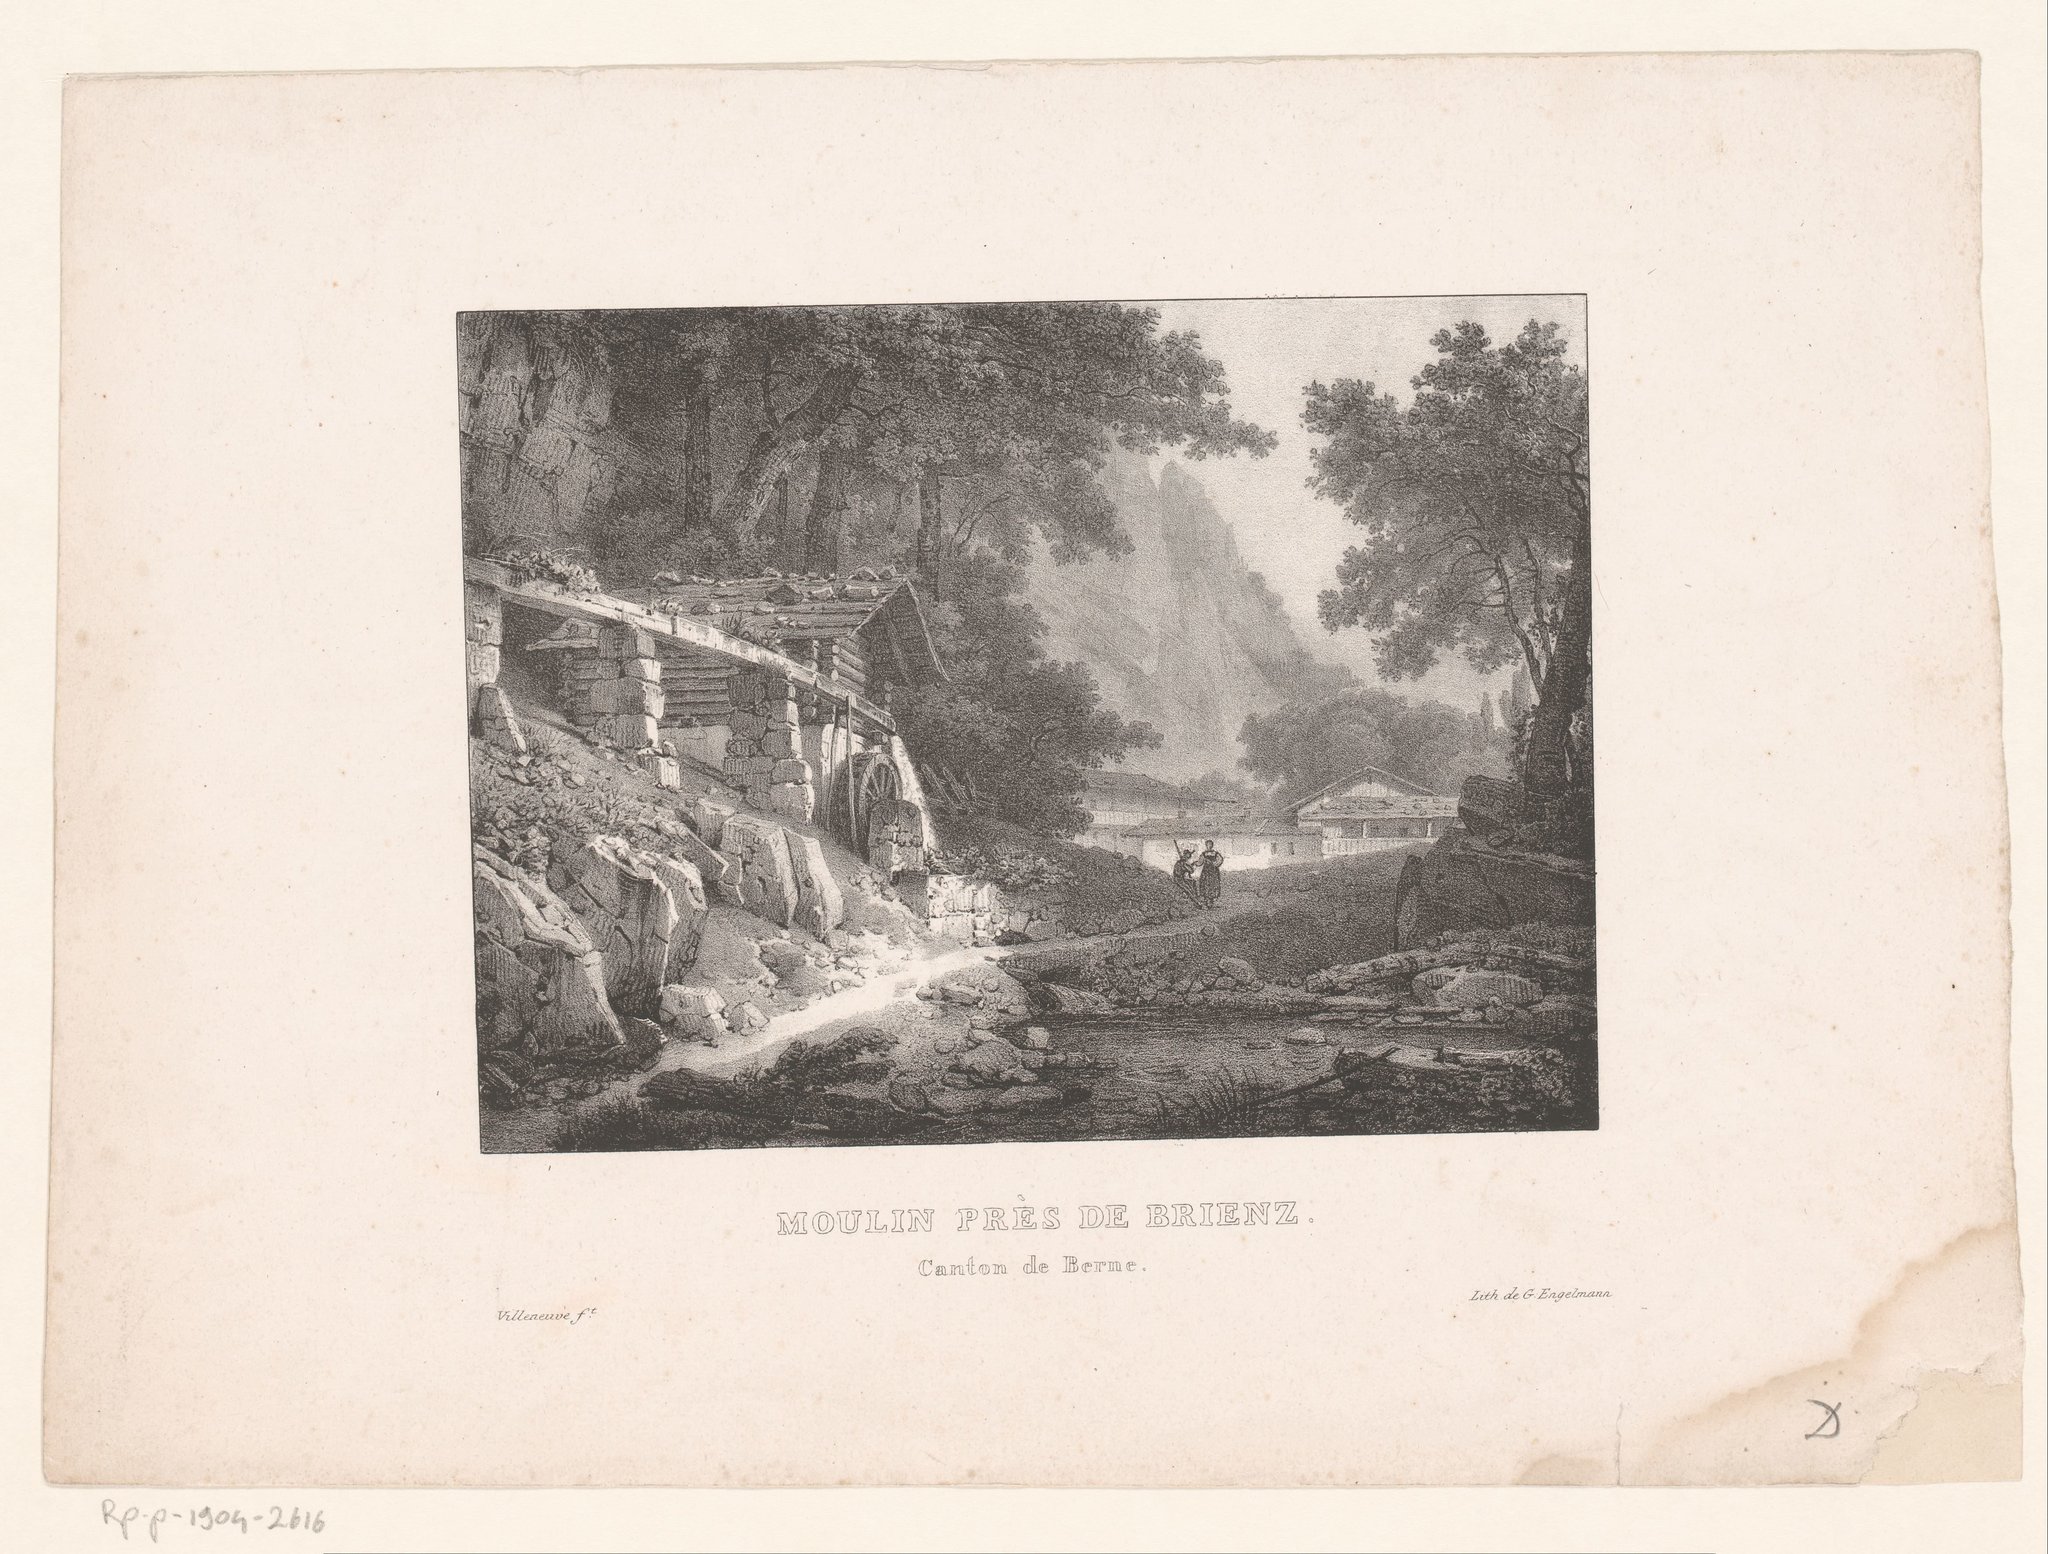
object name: print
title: Watermolen bij Brienz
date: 1823-1832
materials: paper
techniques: lithograph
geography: paris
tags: watermill in landscape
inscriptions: collector's mark: Lugt 2228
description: Prent uit: Lettres sur la Suisse. 5 dln. Parijs: Engelmann & Cie. e.a., 1823-1832. Het is niet duidelijk uit welk deel deze prent komt.